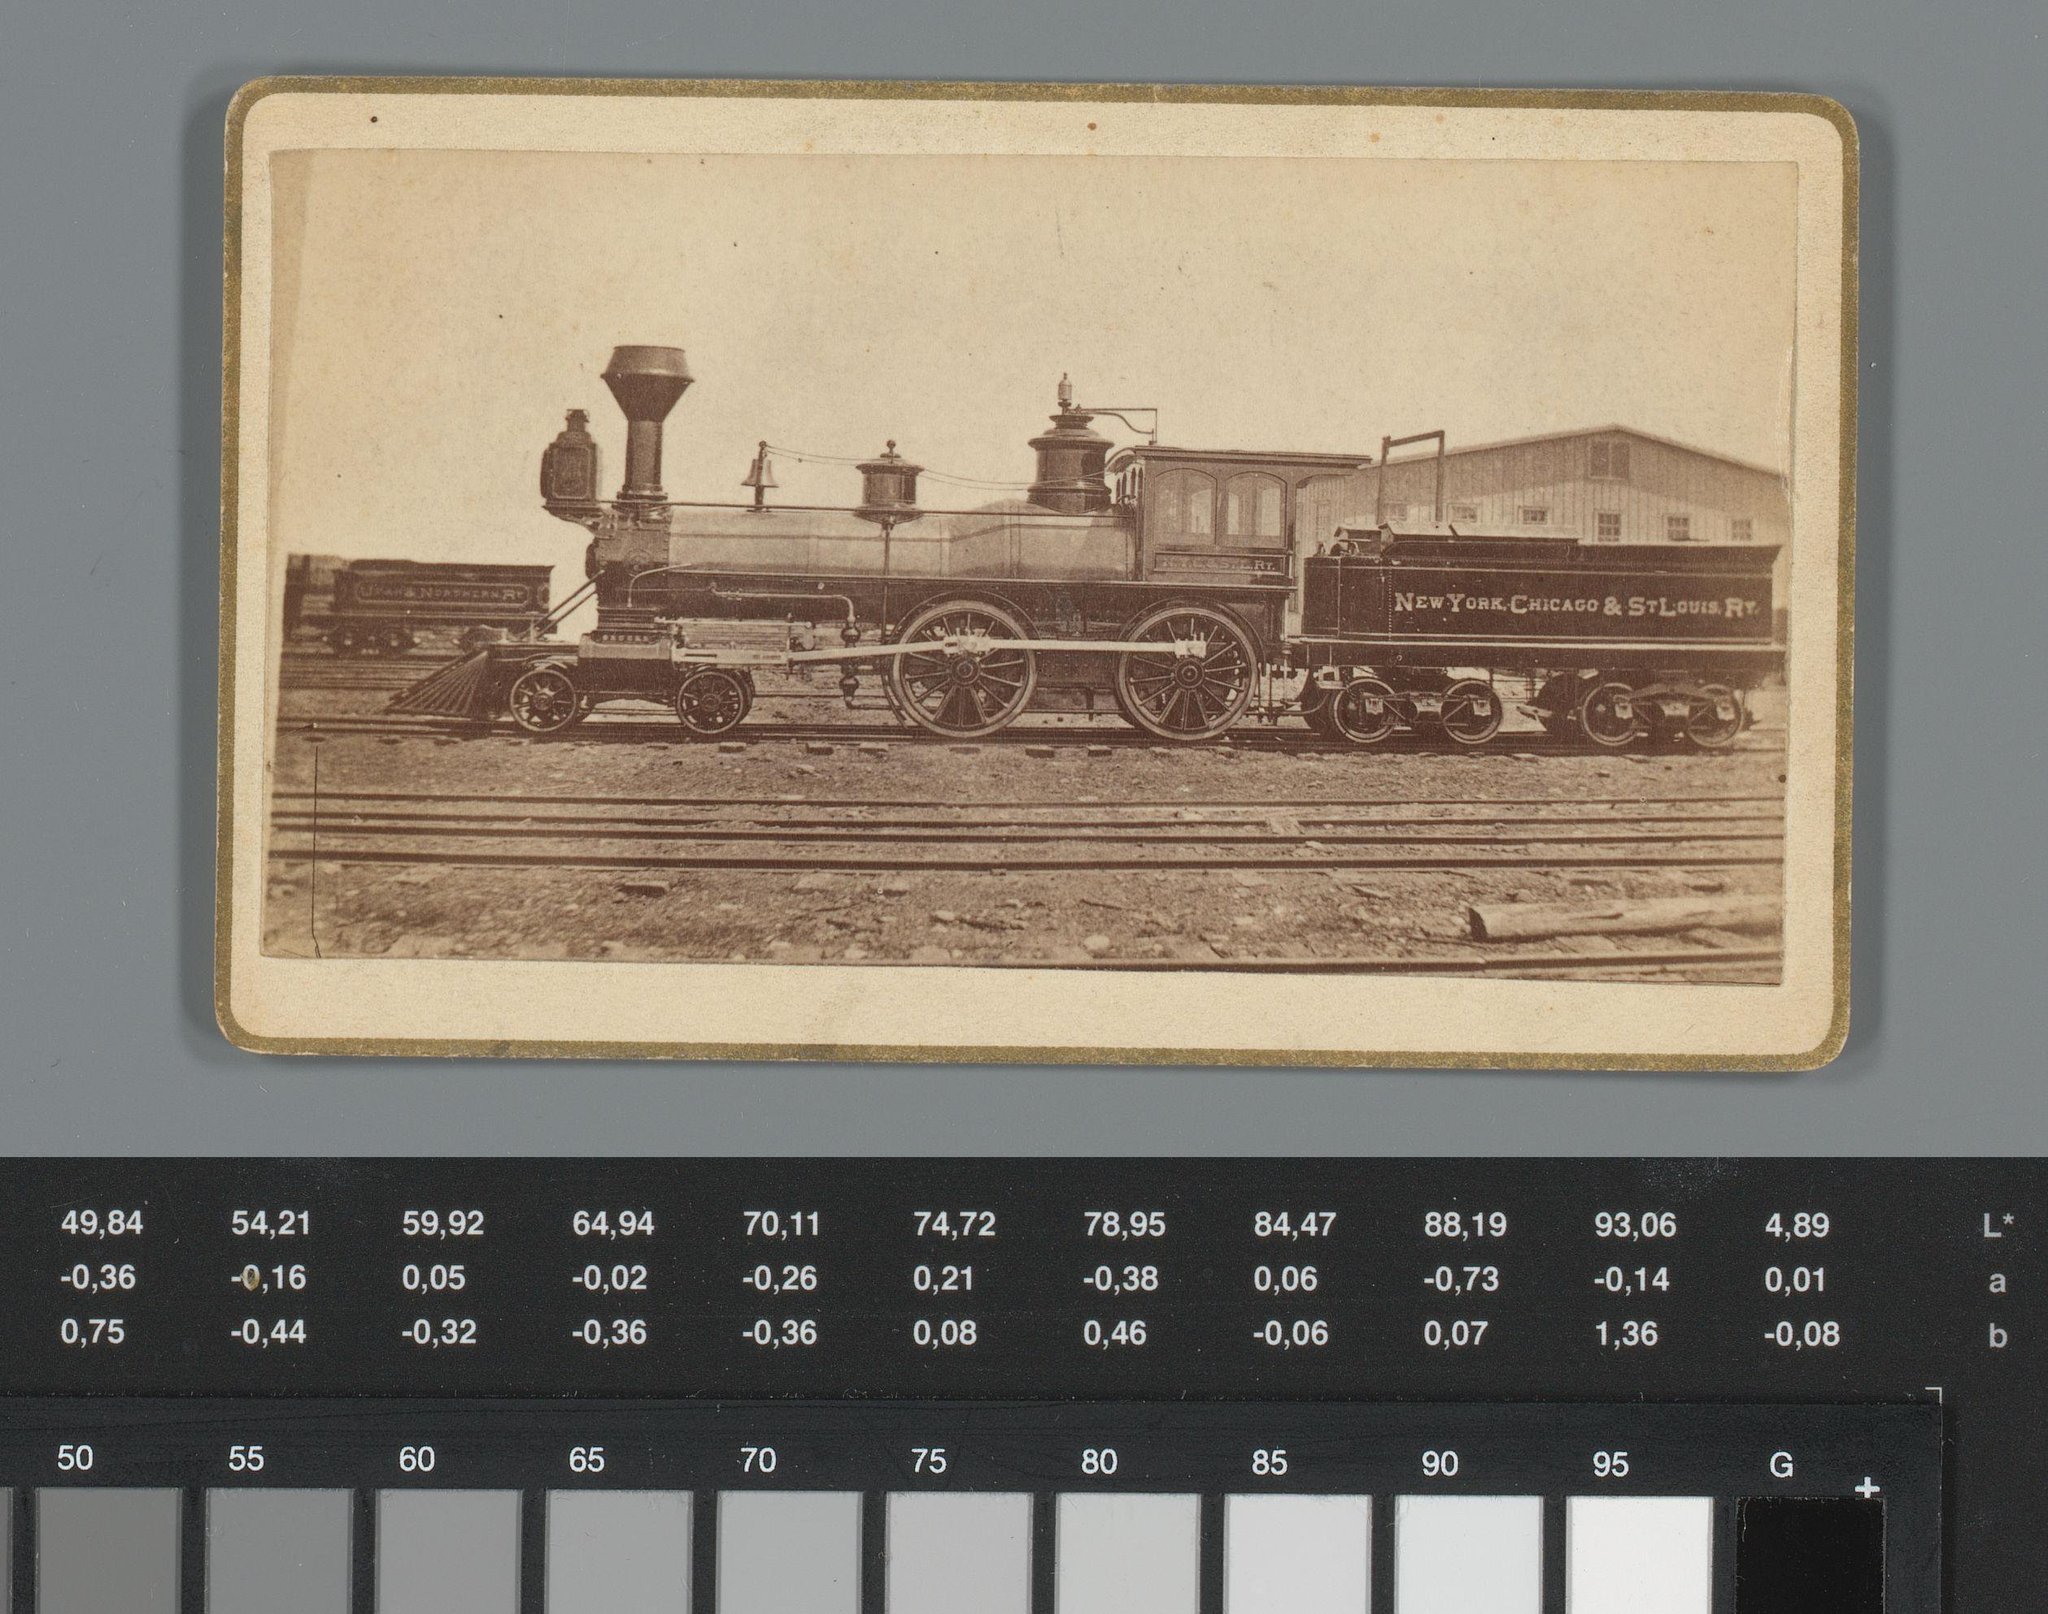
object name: photograph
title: Reclame voor een stoomlocomotief van Brooks Locomotive Woks in Dunkirk, New York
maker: Anonymous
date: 1869-1901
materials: cardboard, photographic support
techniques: albumen print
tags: advertising, steam locomotive, new york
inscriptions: inscription: ‘(...)’